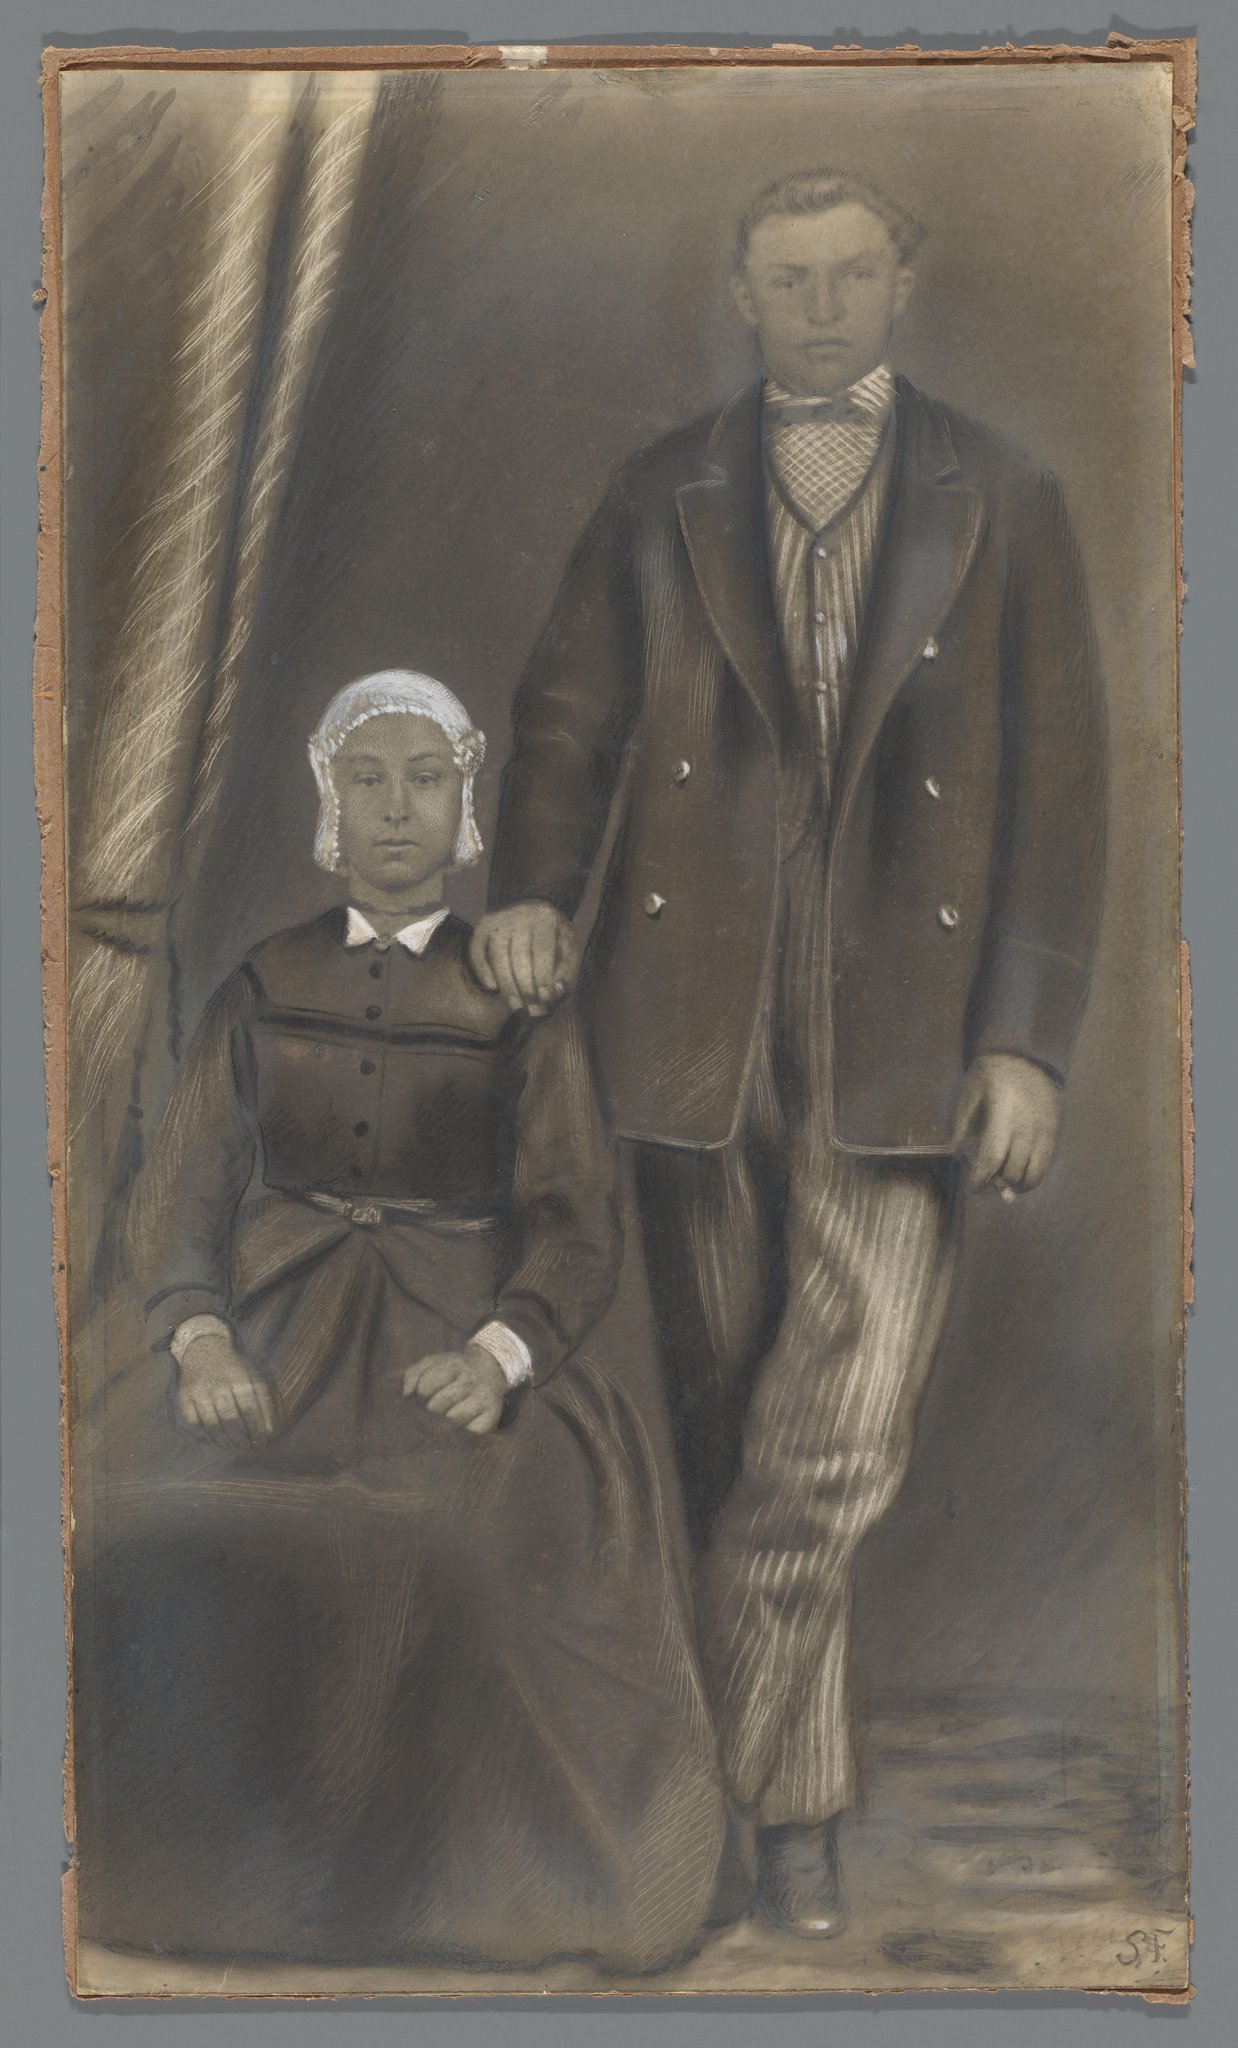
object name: photograph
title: Portret van een boerenechtpaar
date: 1900-1925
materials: cardboard, photographic support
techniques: gelatin silver print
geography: netherlands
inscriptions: signature: ‘F.S.’